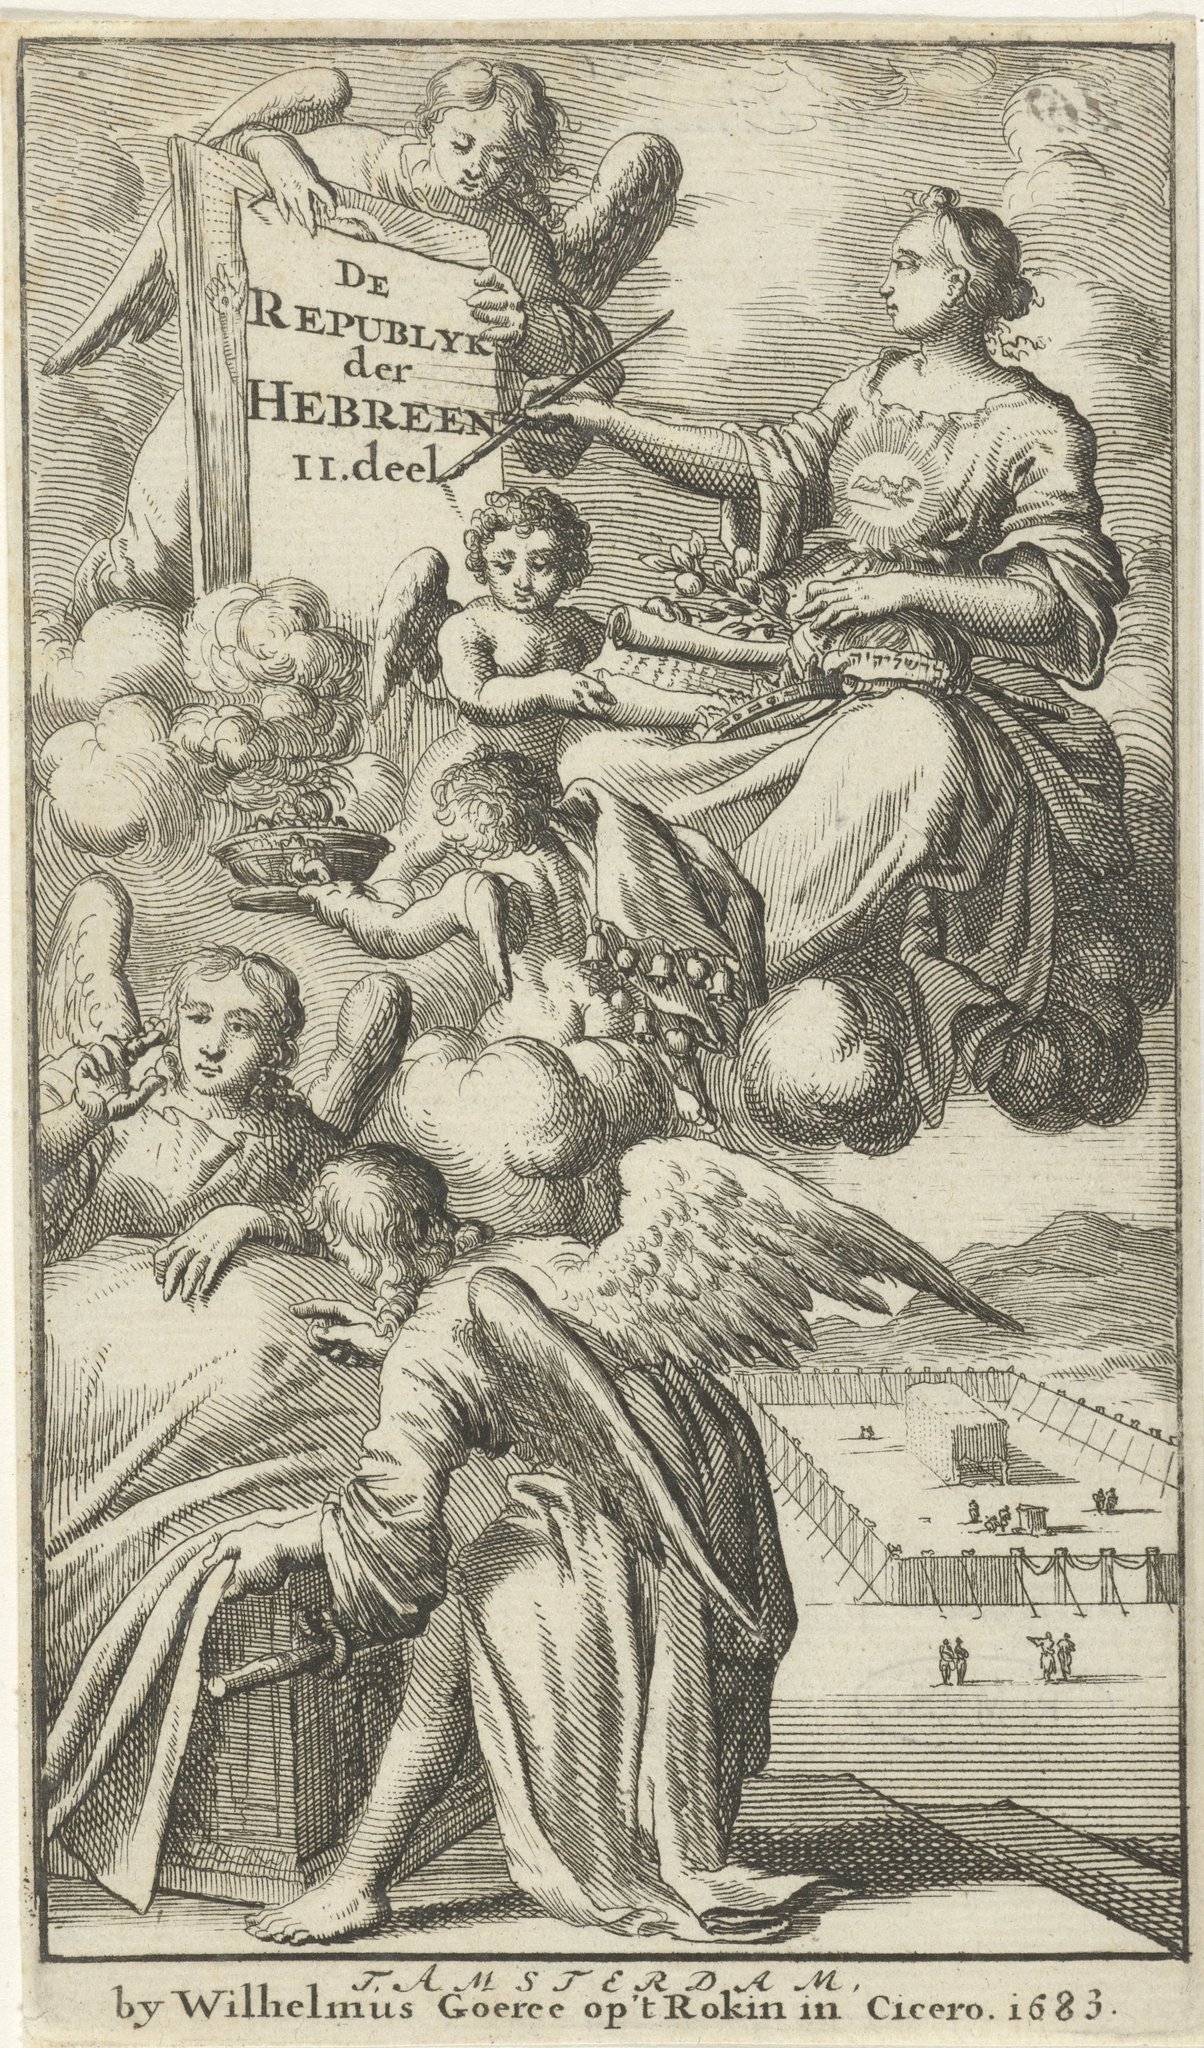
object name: titelblad, titelpagina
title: Allegorische vrouwenfiguur beschildert in de wolken een paneel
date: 1683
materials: paper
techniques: etching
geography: amsterdam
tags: ark of the covenant ~ jewish religion, painting (including book-illumination, miniature-painting), angels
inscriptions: collector's mark: Lugt 2228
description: Een allegorische vrouwenfiguur beschildert in de wolken een paneel dat door een engel wordt vastgehouden. Hieronder bewaken twee engelen de Ark des Verbonds.